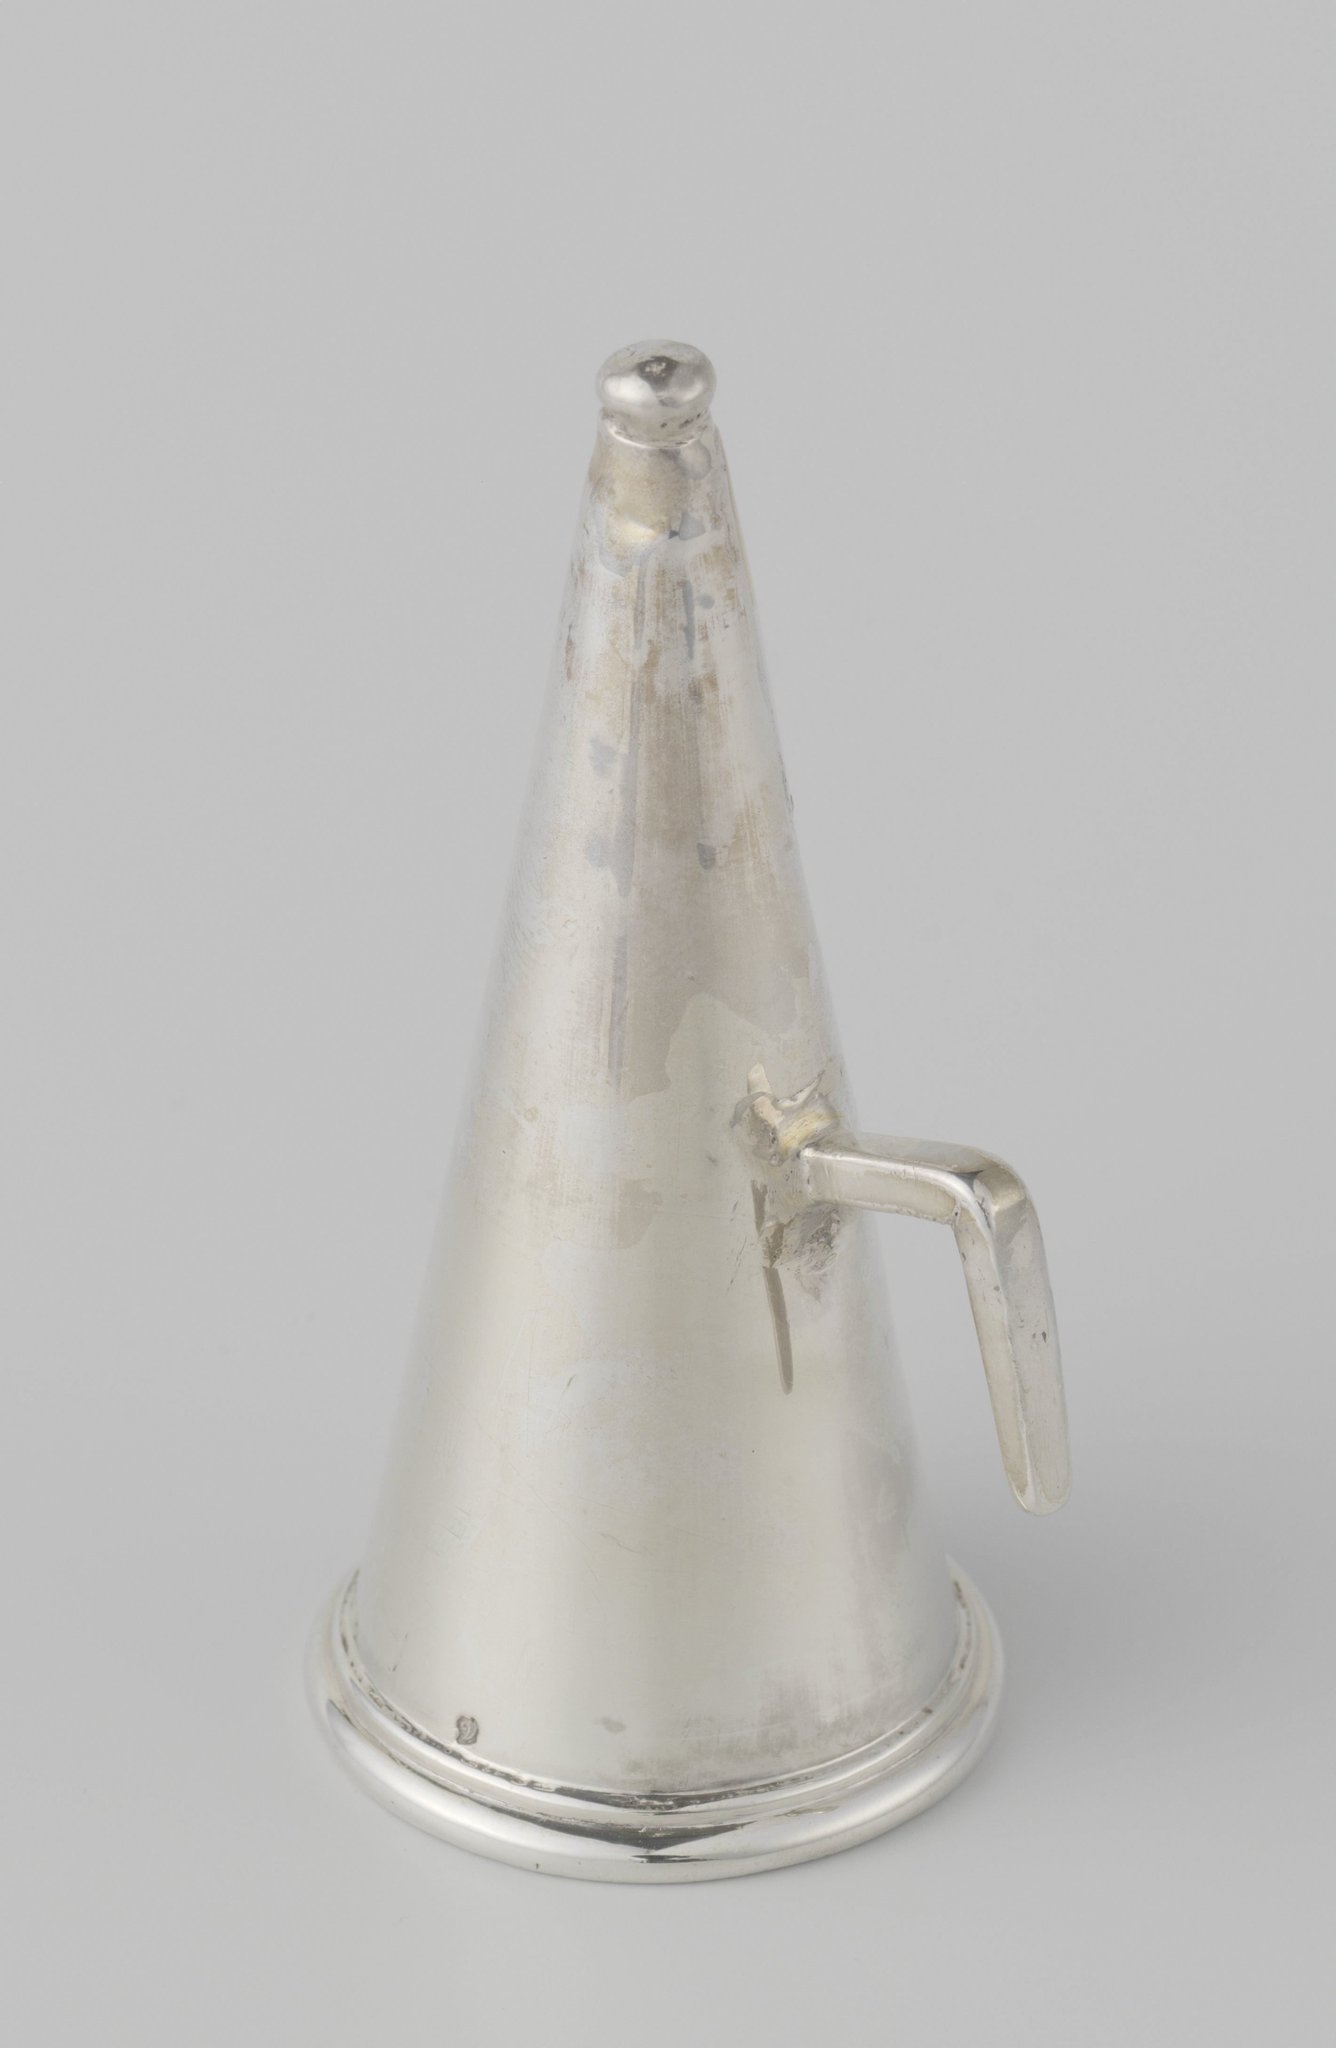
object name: extinguisher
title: Domper, rond, met geprofileerde onderrand en bekroond met klein samengedrukt bolvormige knop. Halverwege een haak die in het oog van de blaker past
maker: Anonymous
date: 1748-1749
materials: silver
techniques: casting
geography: the hague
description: Chamberstick with extinguisher and snuffers. Silver. The Hague, 1748, by Reynier de Haan.